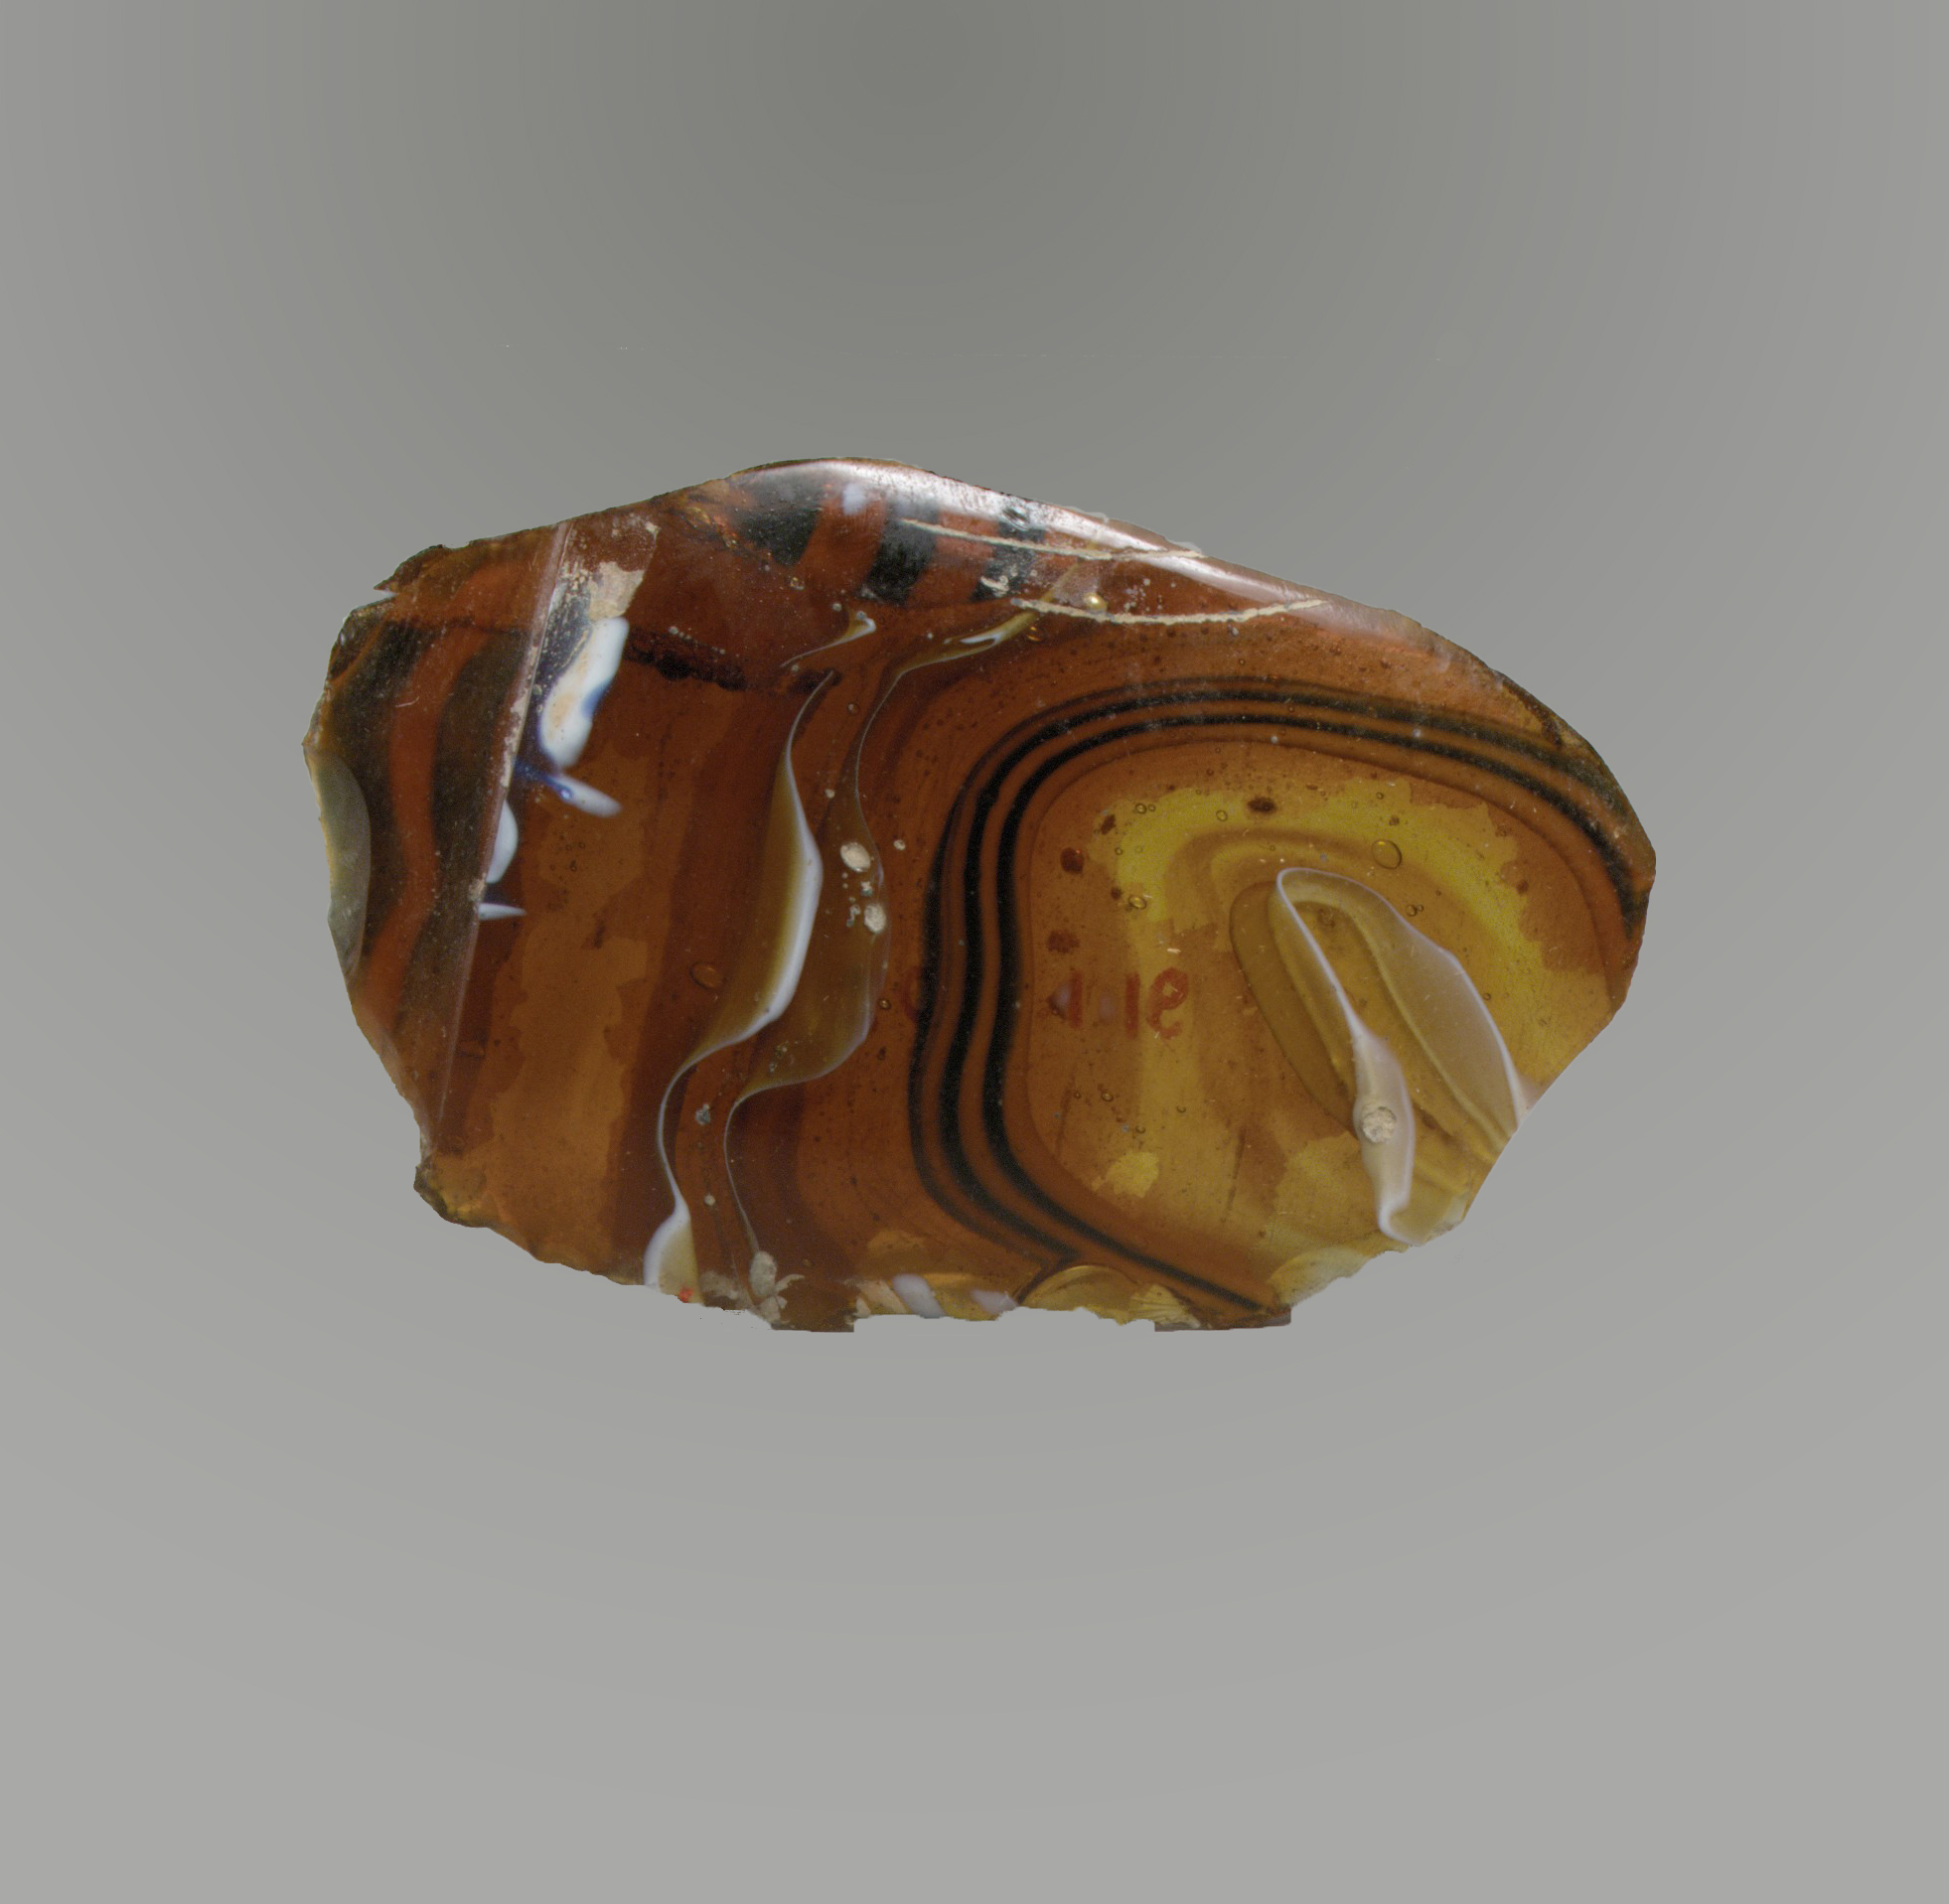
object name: fragment, mosaic bowl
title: Glass mosaic bowl fragment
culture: roman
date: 34 BCE-33 CE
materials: glass